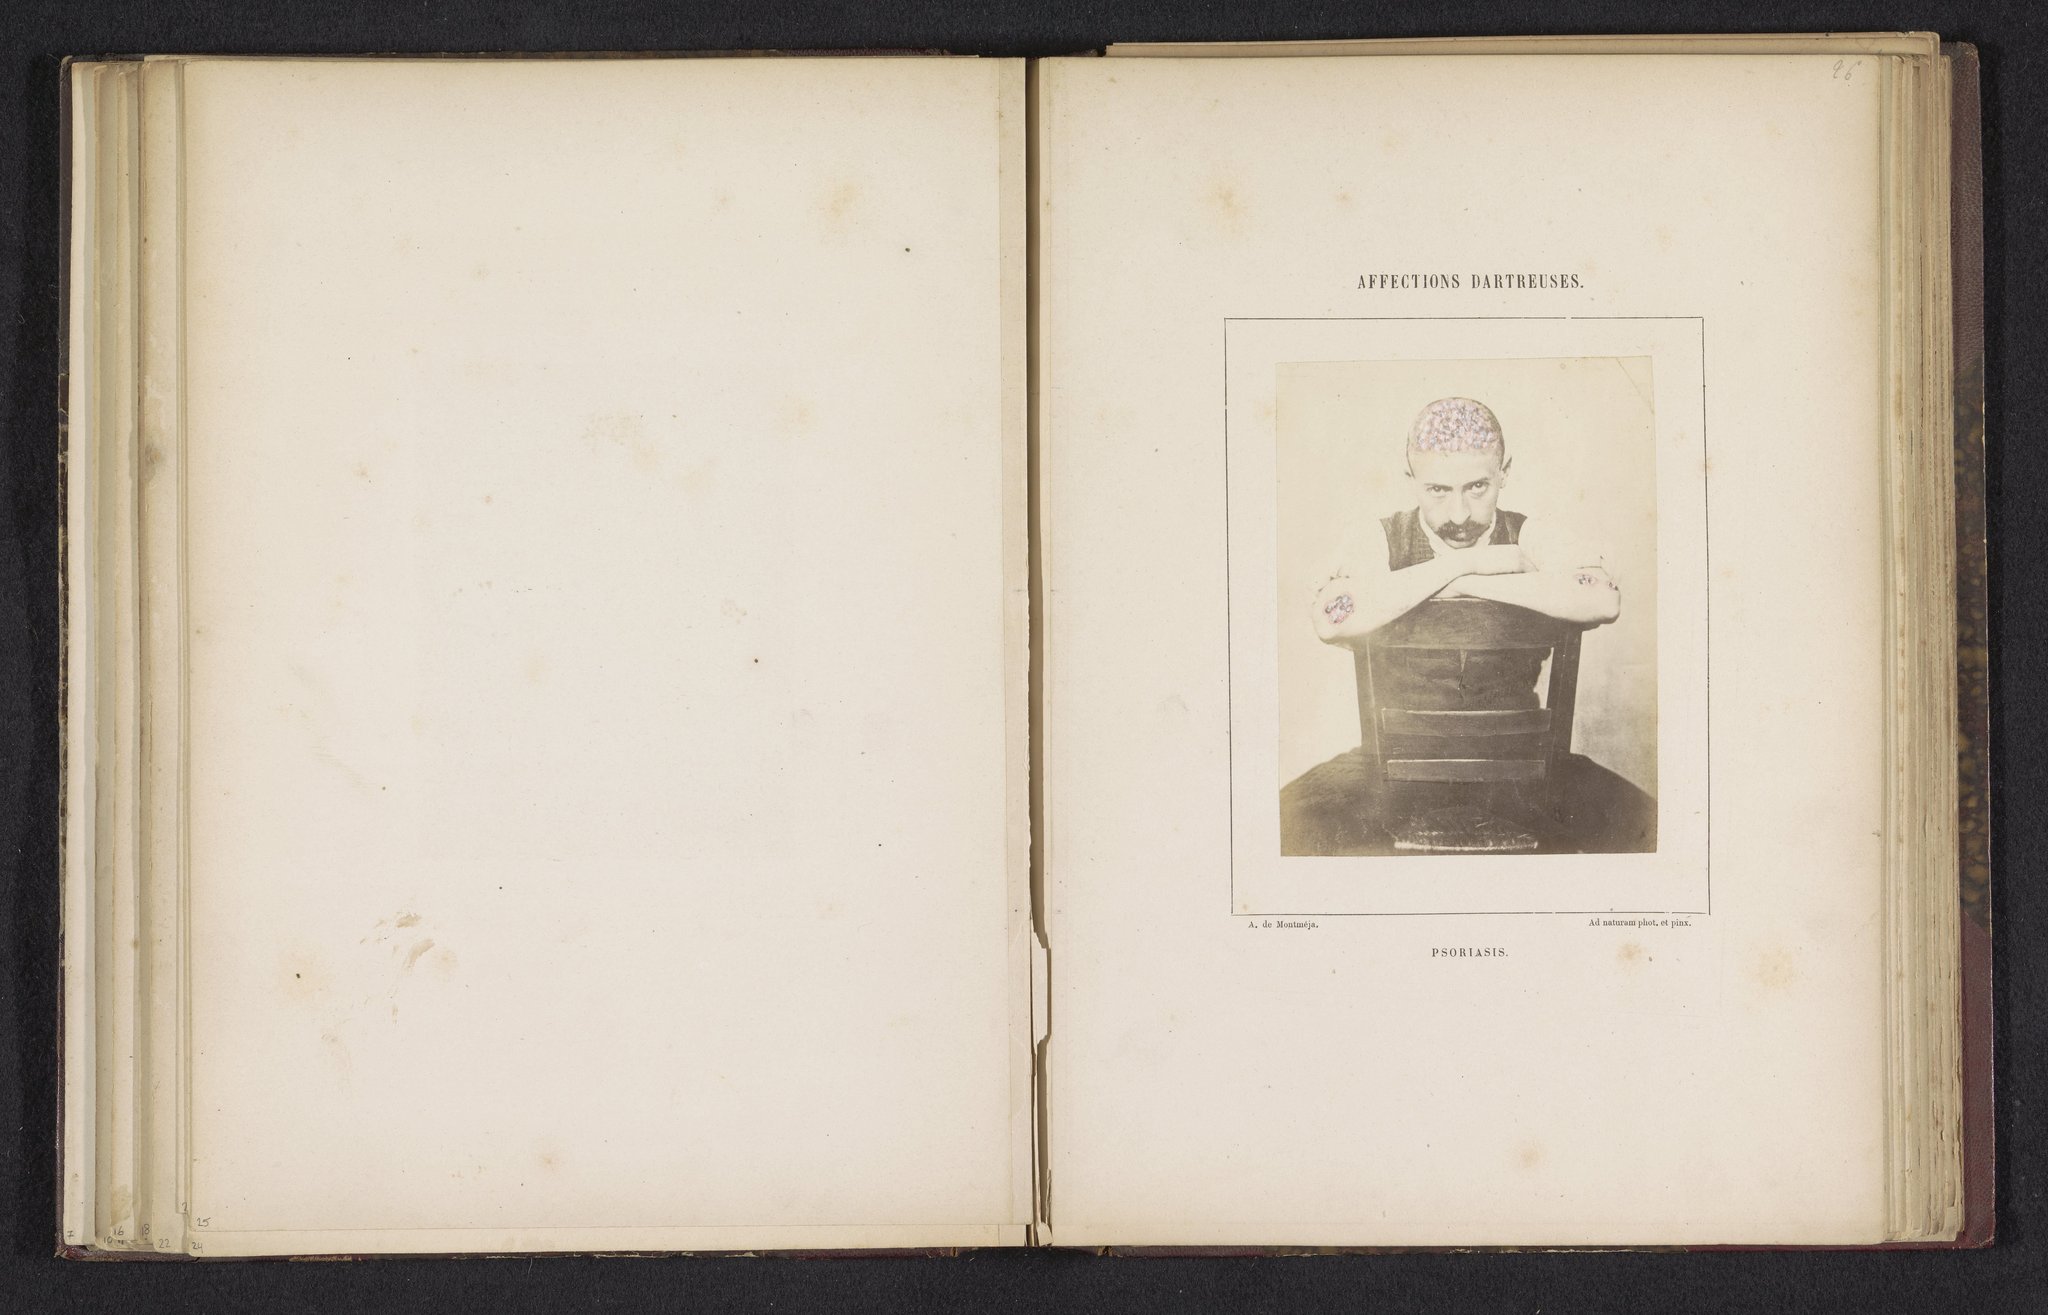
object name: photograph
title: Psoriasis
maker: a. de montméja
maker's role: arts, fotograaf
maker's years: 1841-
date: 1860-1868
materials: photographic support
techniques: albumen print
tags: skin and venereal diseases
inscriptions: inscription: ‘Ad naturam phot. et pinx.’, inscription: ‘Affections dartreuses’, number: ‘26’